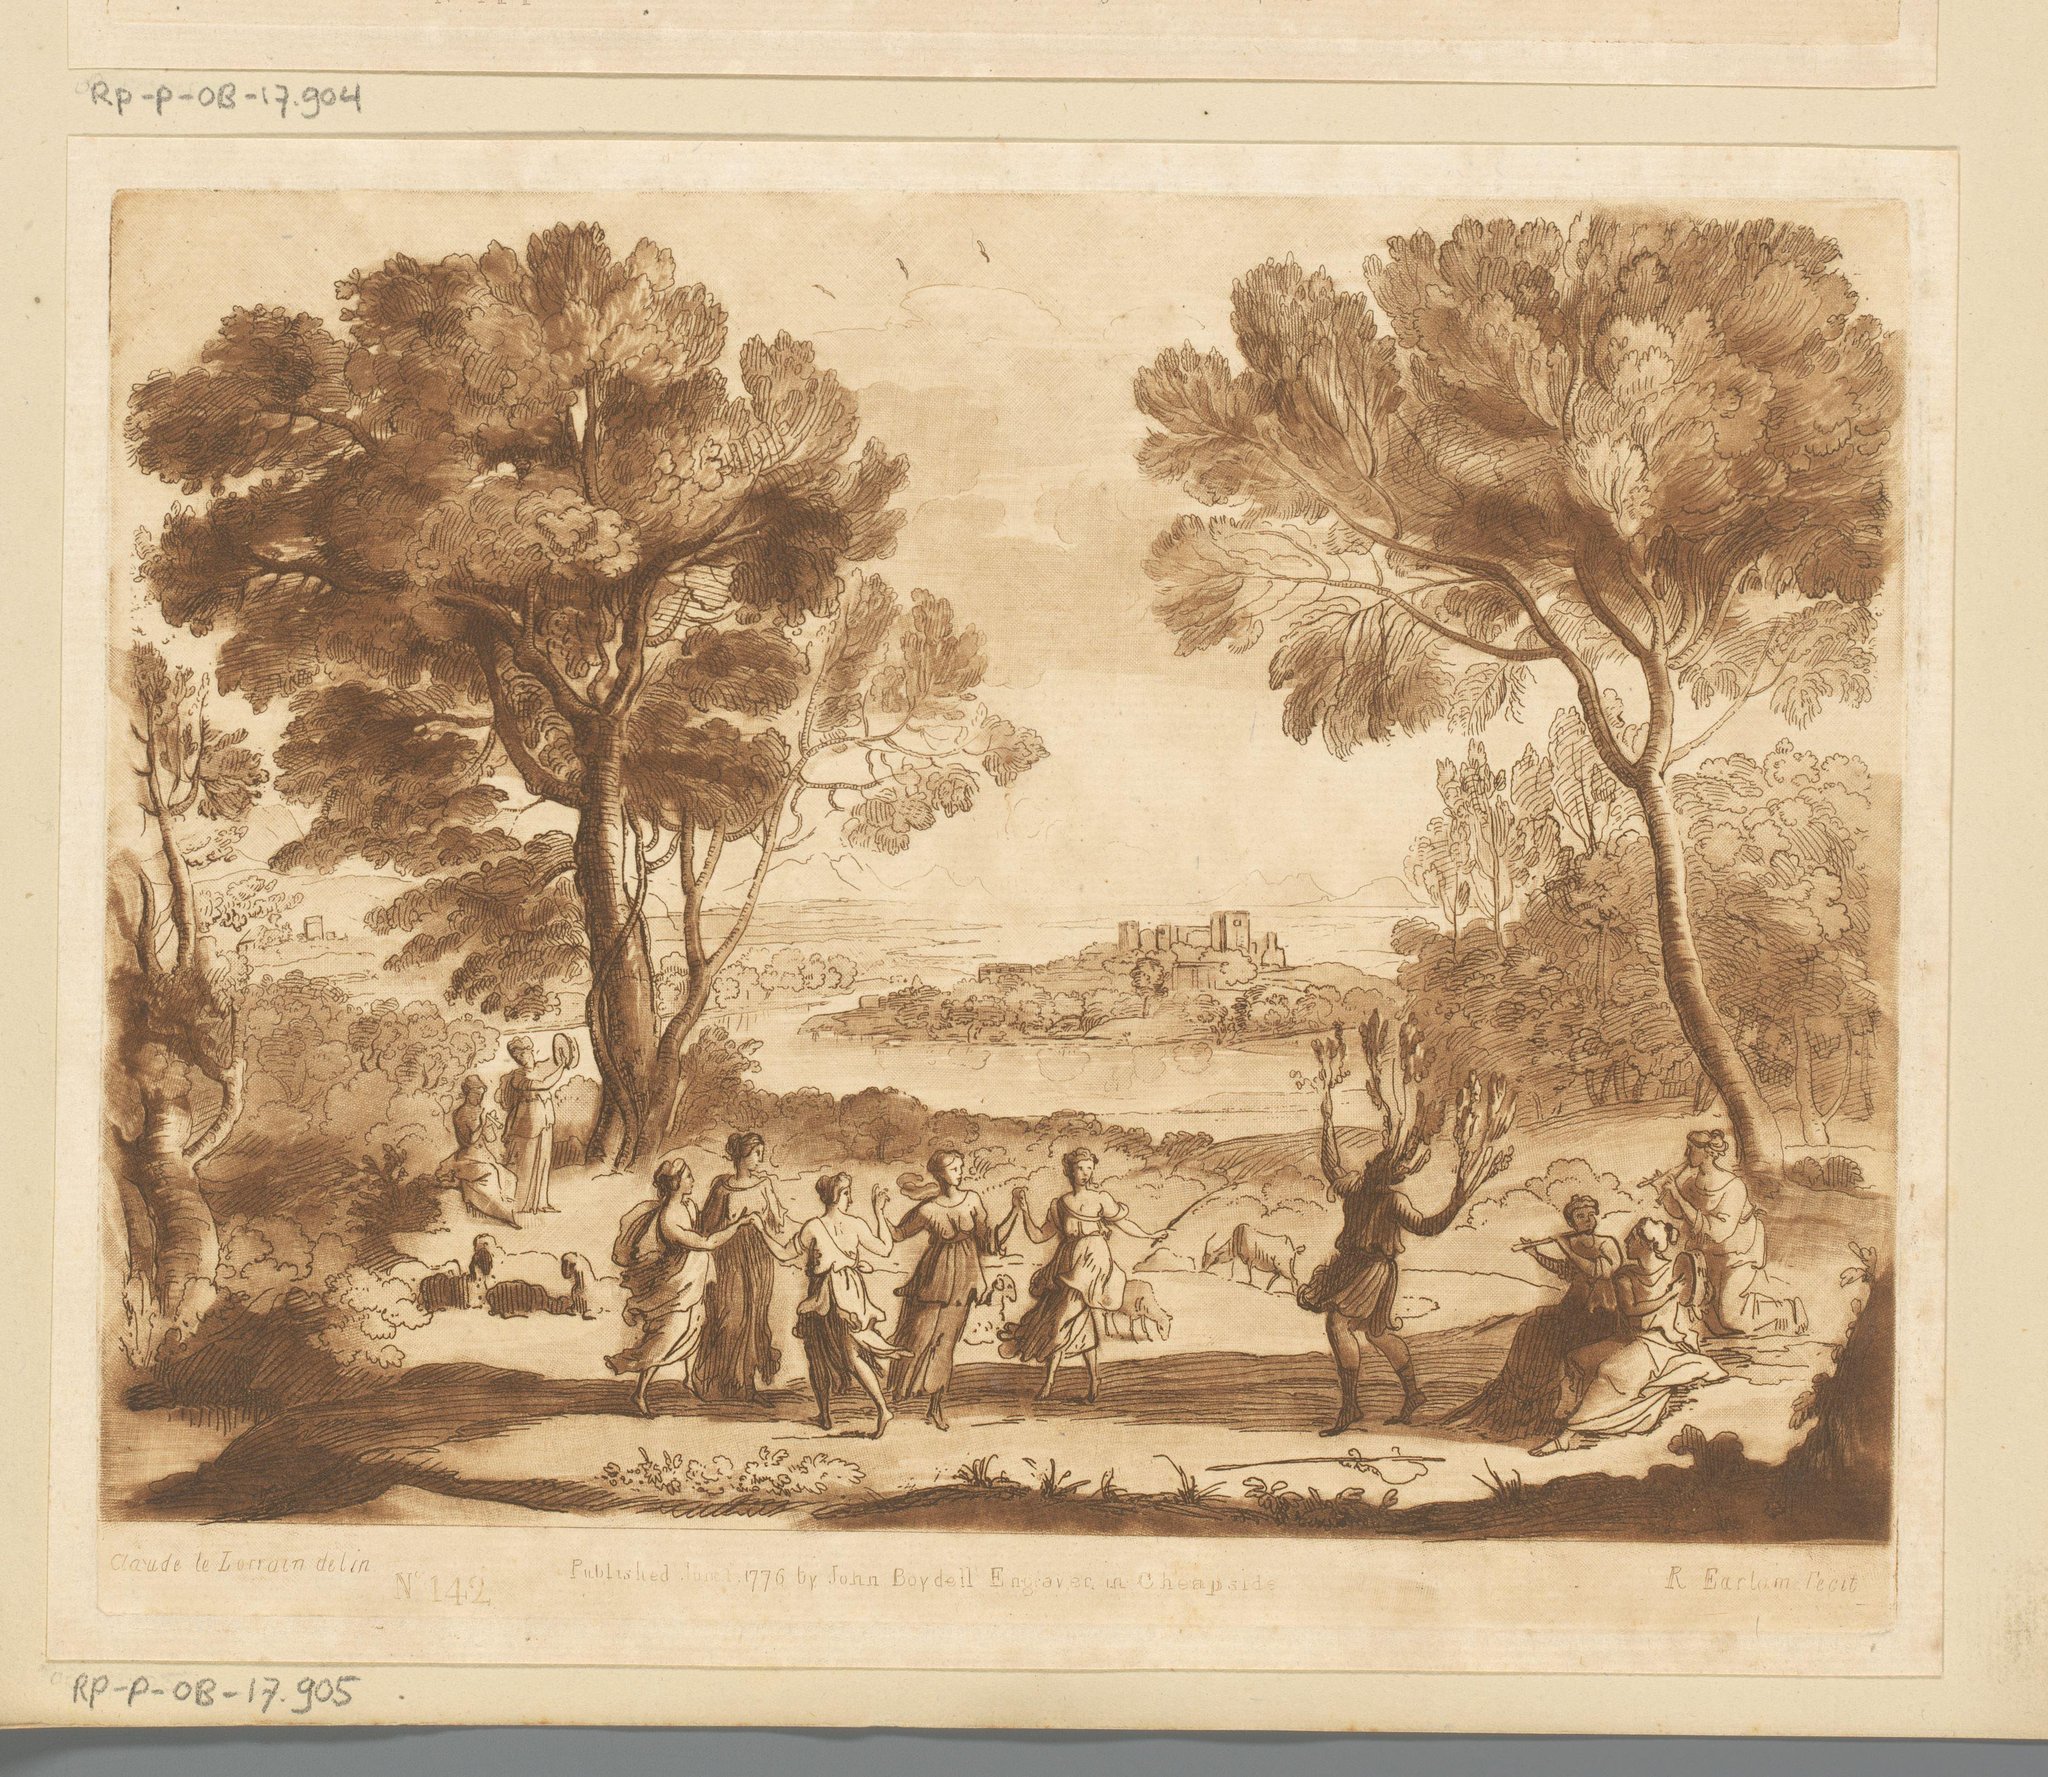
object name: print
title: Landschap met Apulische herder veranderend in een olijfboom en dansende nimfen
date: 1776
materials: paper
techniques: etching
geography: london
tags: river - hh - ideal landscapes, dancing, the apulian shepherd changed into an oleaster: the apulian shepherd is changed into an oleaster as punishment for mocking dancing nymphs (ovid, metamorphoses xiv 521)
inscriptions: date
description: Vanaf 1774 publiceerde John Boydell tweehonderd prenten naar het tekeningenboek Liber Veritatis van Claude Lorrain, in het bezit van de hertogen van Cavendish. Deze prenten werden vanaf 1777 in twee volumes gebundeld uitgegeven.